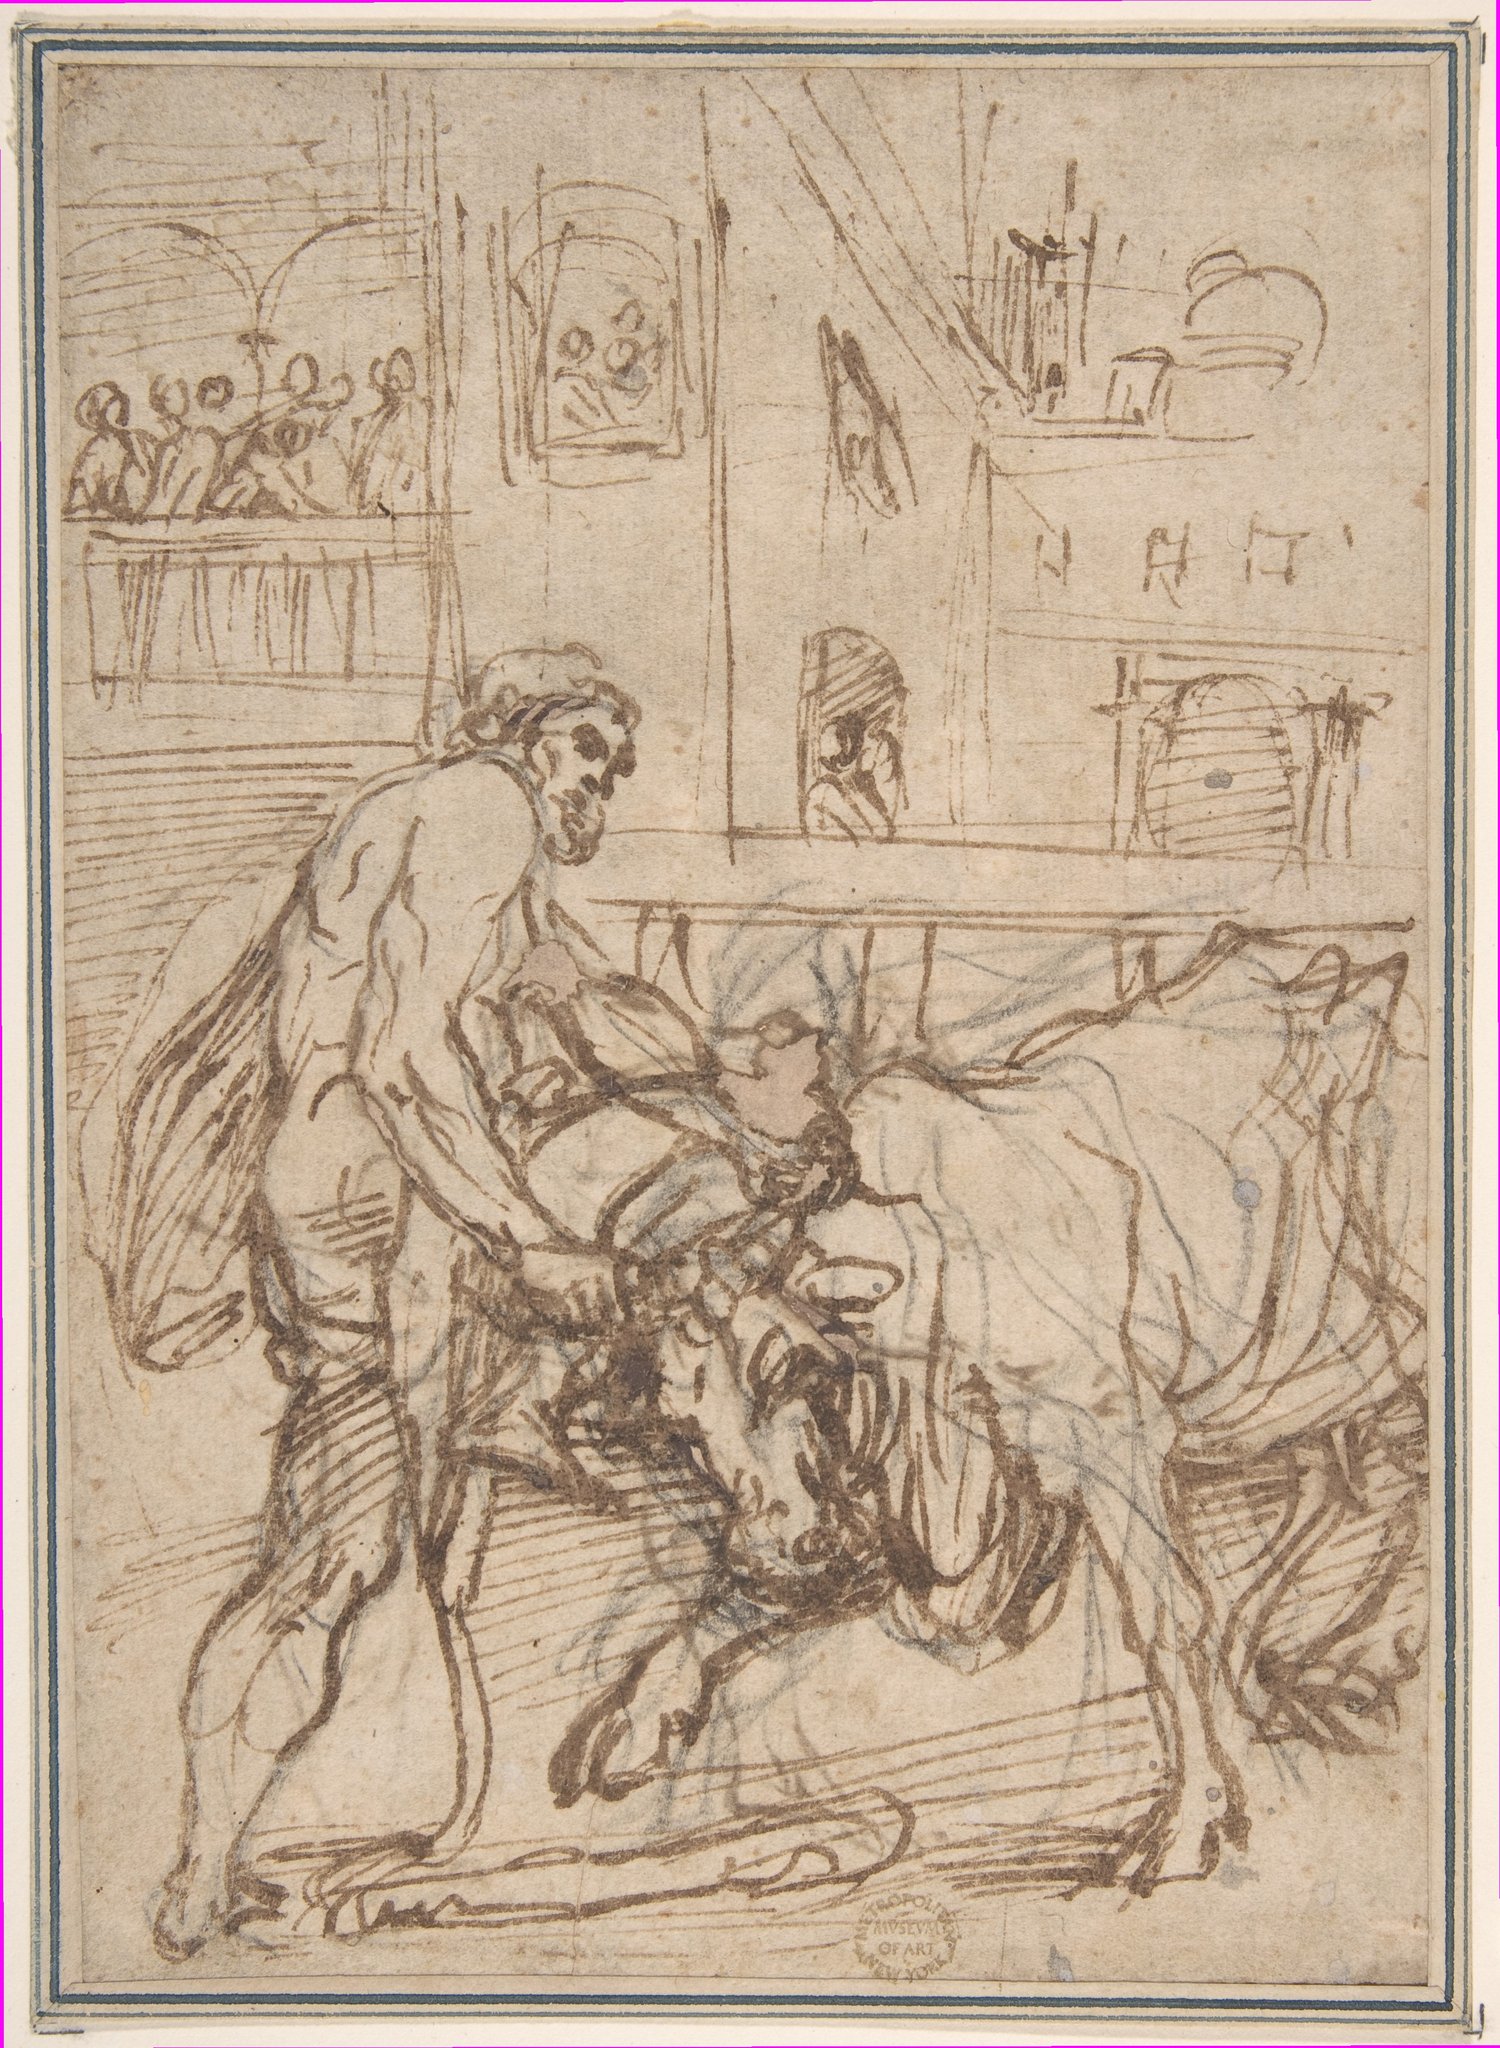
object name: drawing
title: Hercules Capturing the Cretan Bull, from "The Labors of Hercules"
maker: anonymous, italian, roman-bolognese, 17th century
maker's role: artist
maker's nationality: italian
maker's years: 1600-1700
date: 1601-1700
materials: chalk, ink, paper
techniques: pen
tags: hercules,bulls